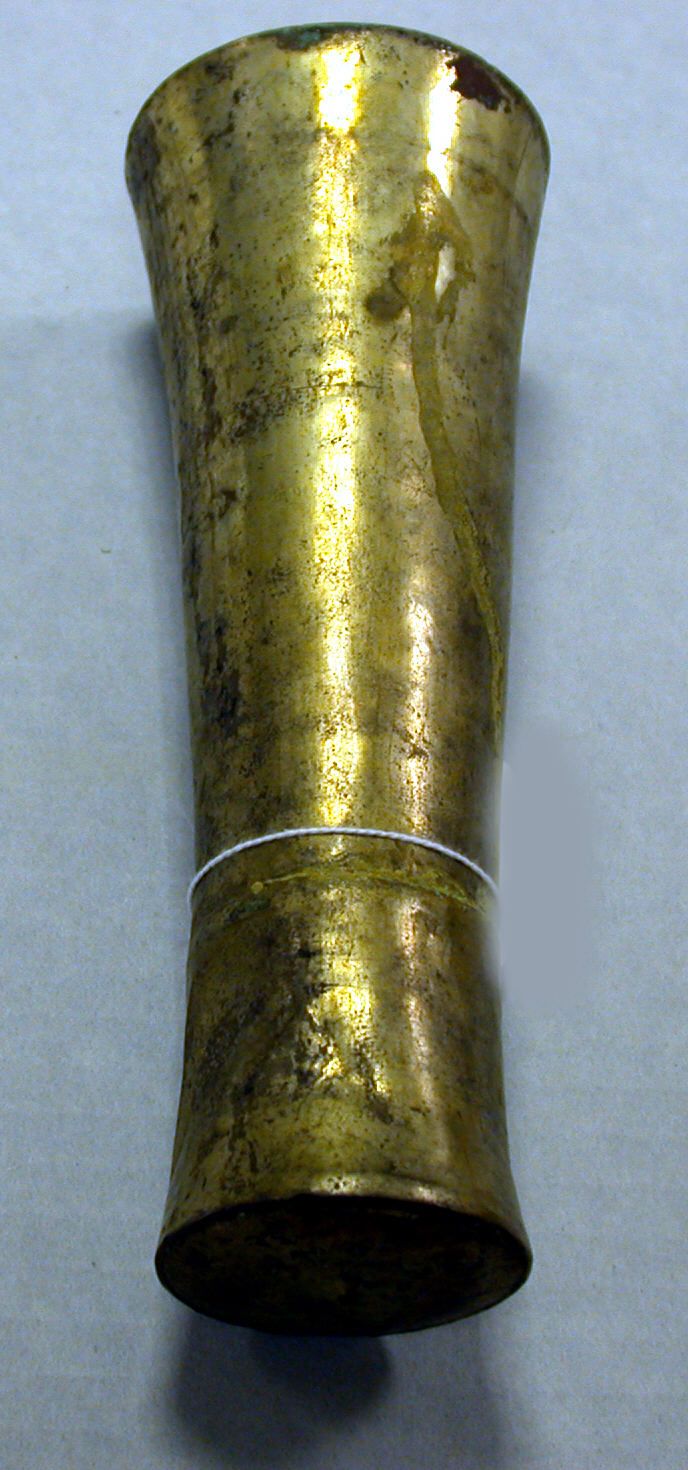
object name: rattle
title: Hammered Silver Rattle Beaker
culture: peruvian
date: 701-1566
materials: gilt, silver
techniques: hammering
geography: peru